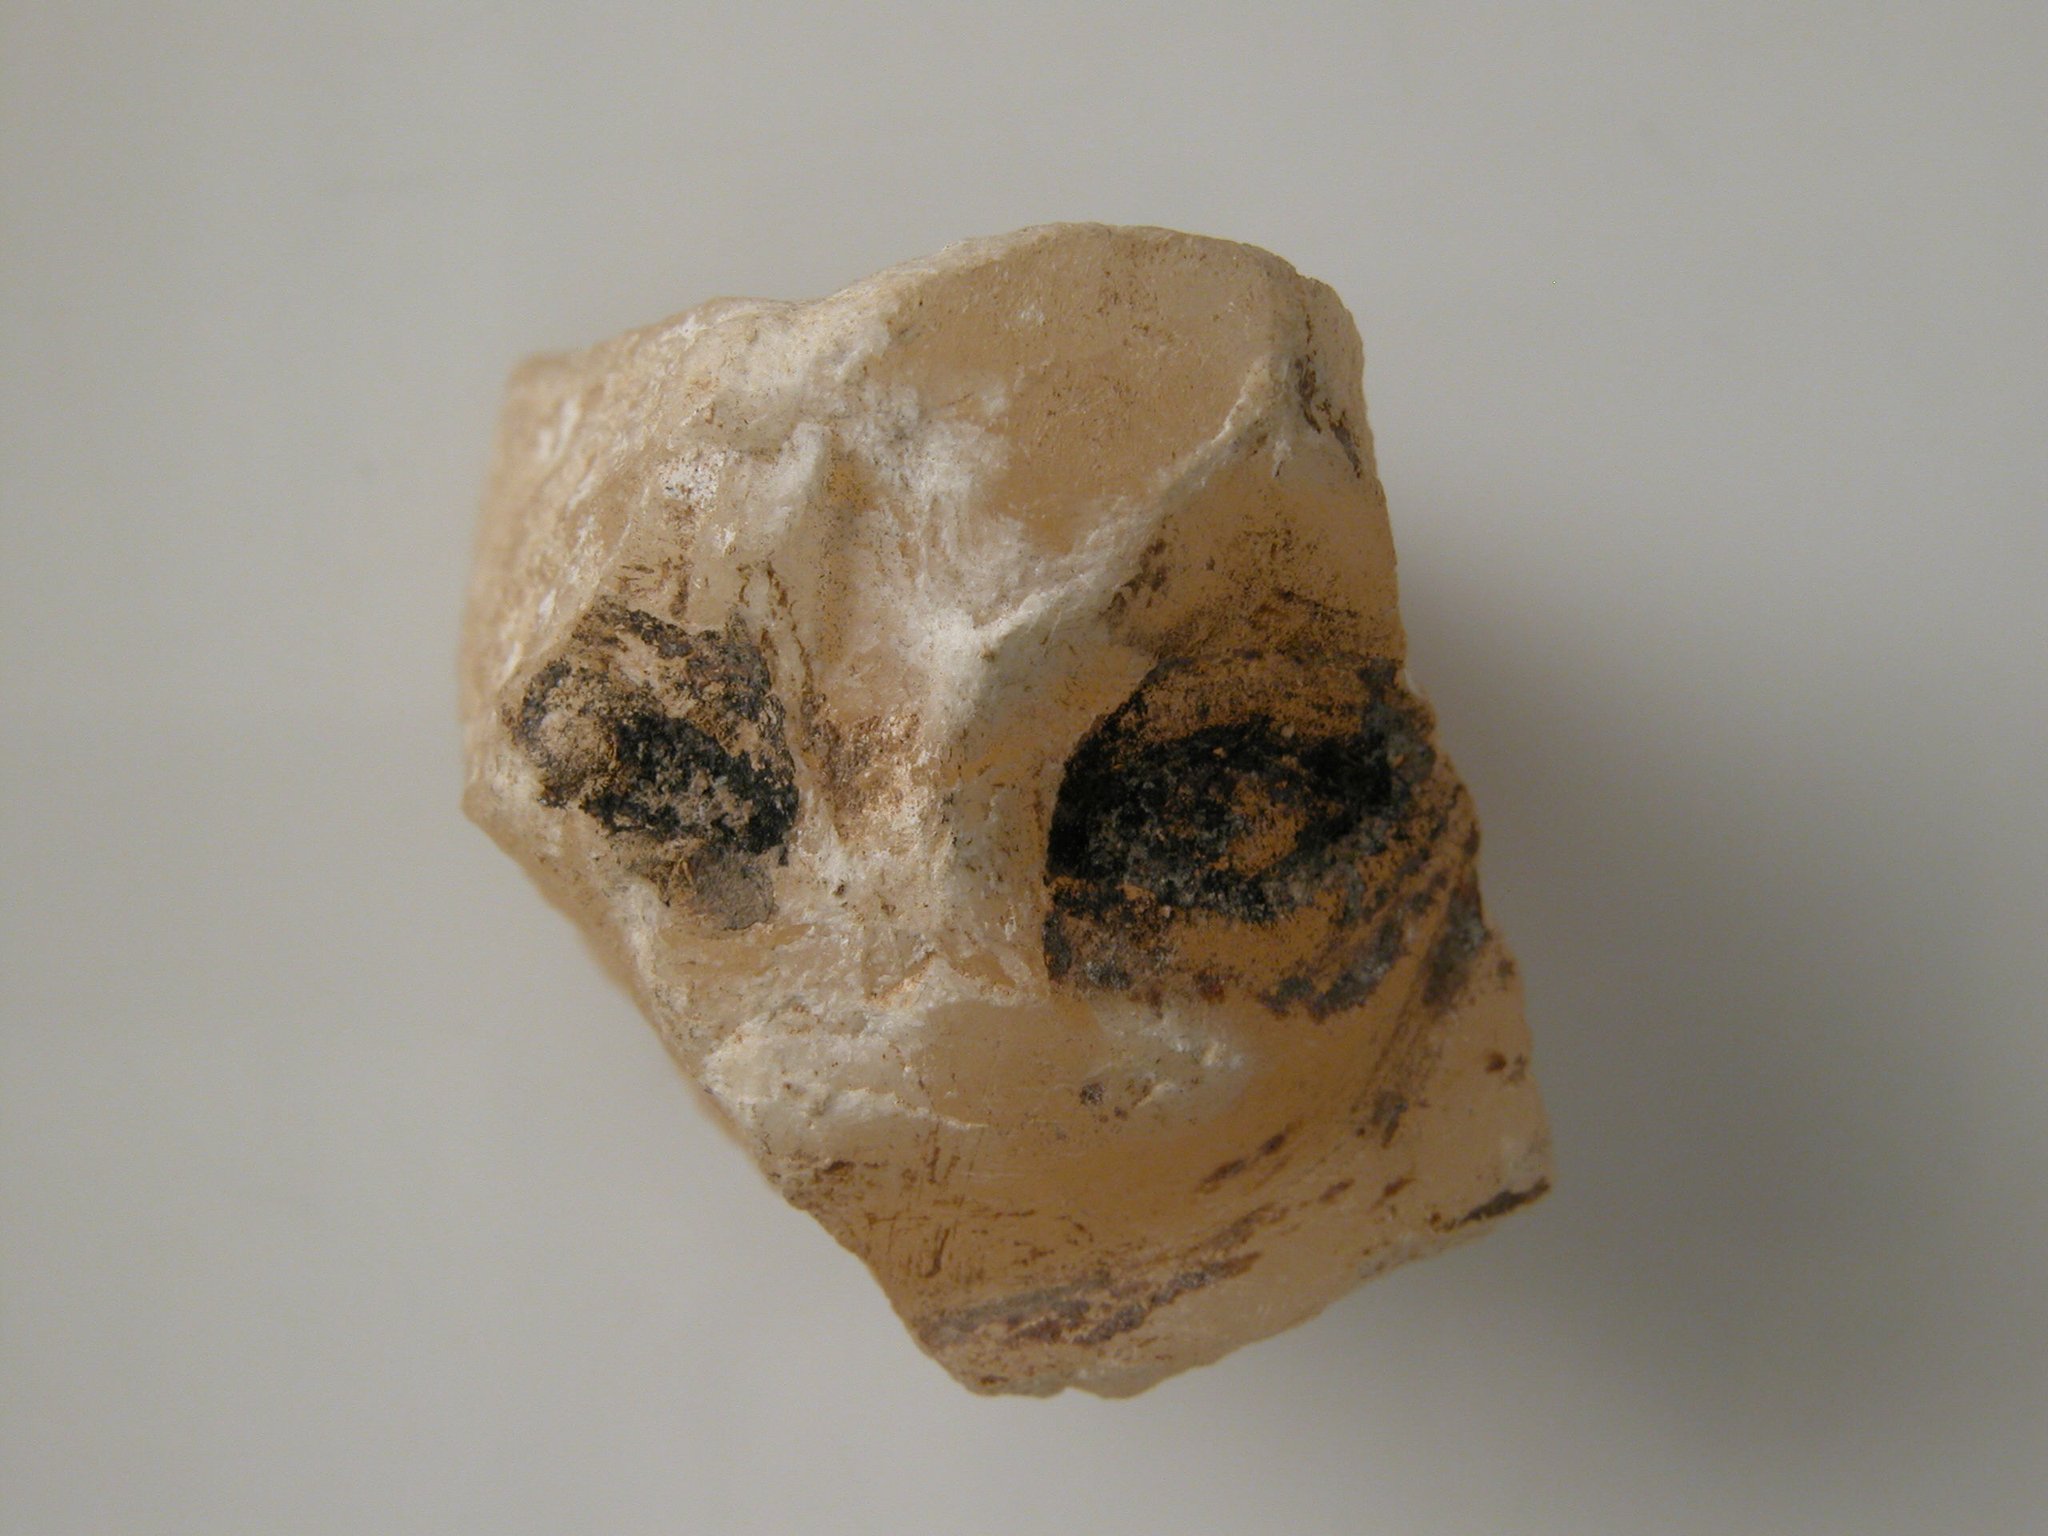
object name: statuette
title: Face Fragment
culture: coptic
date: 301-700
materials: stone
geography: egypt